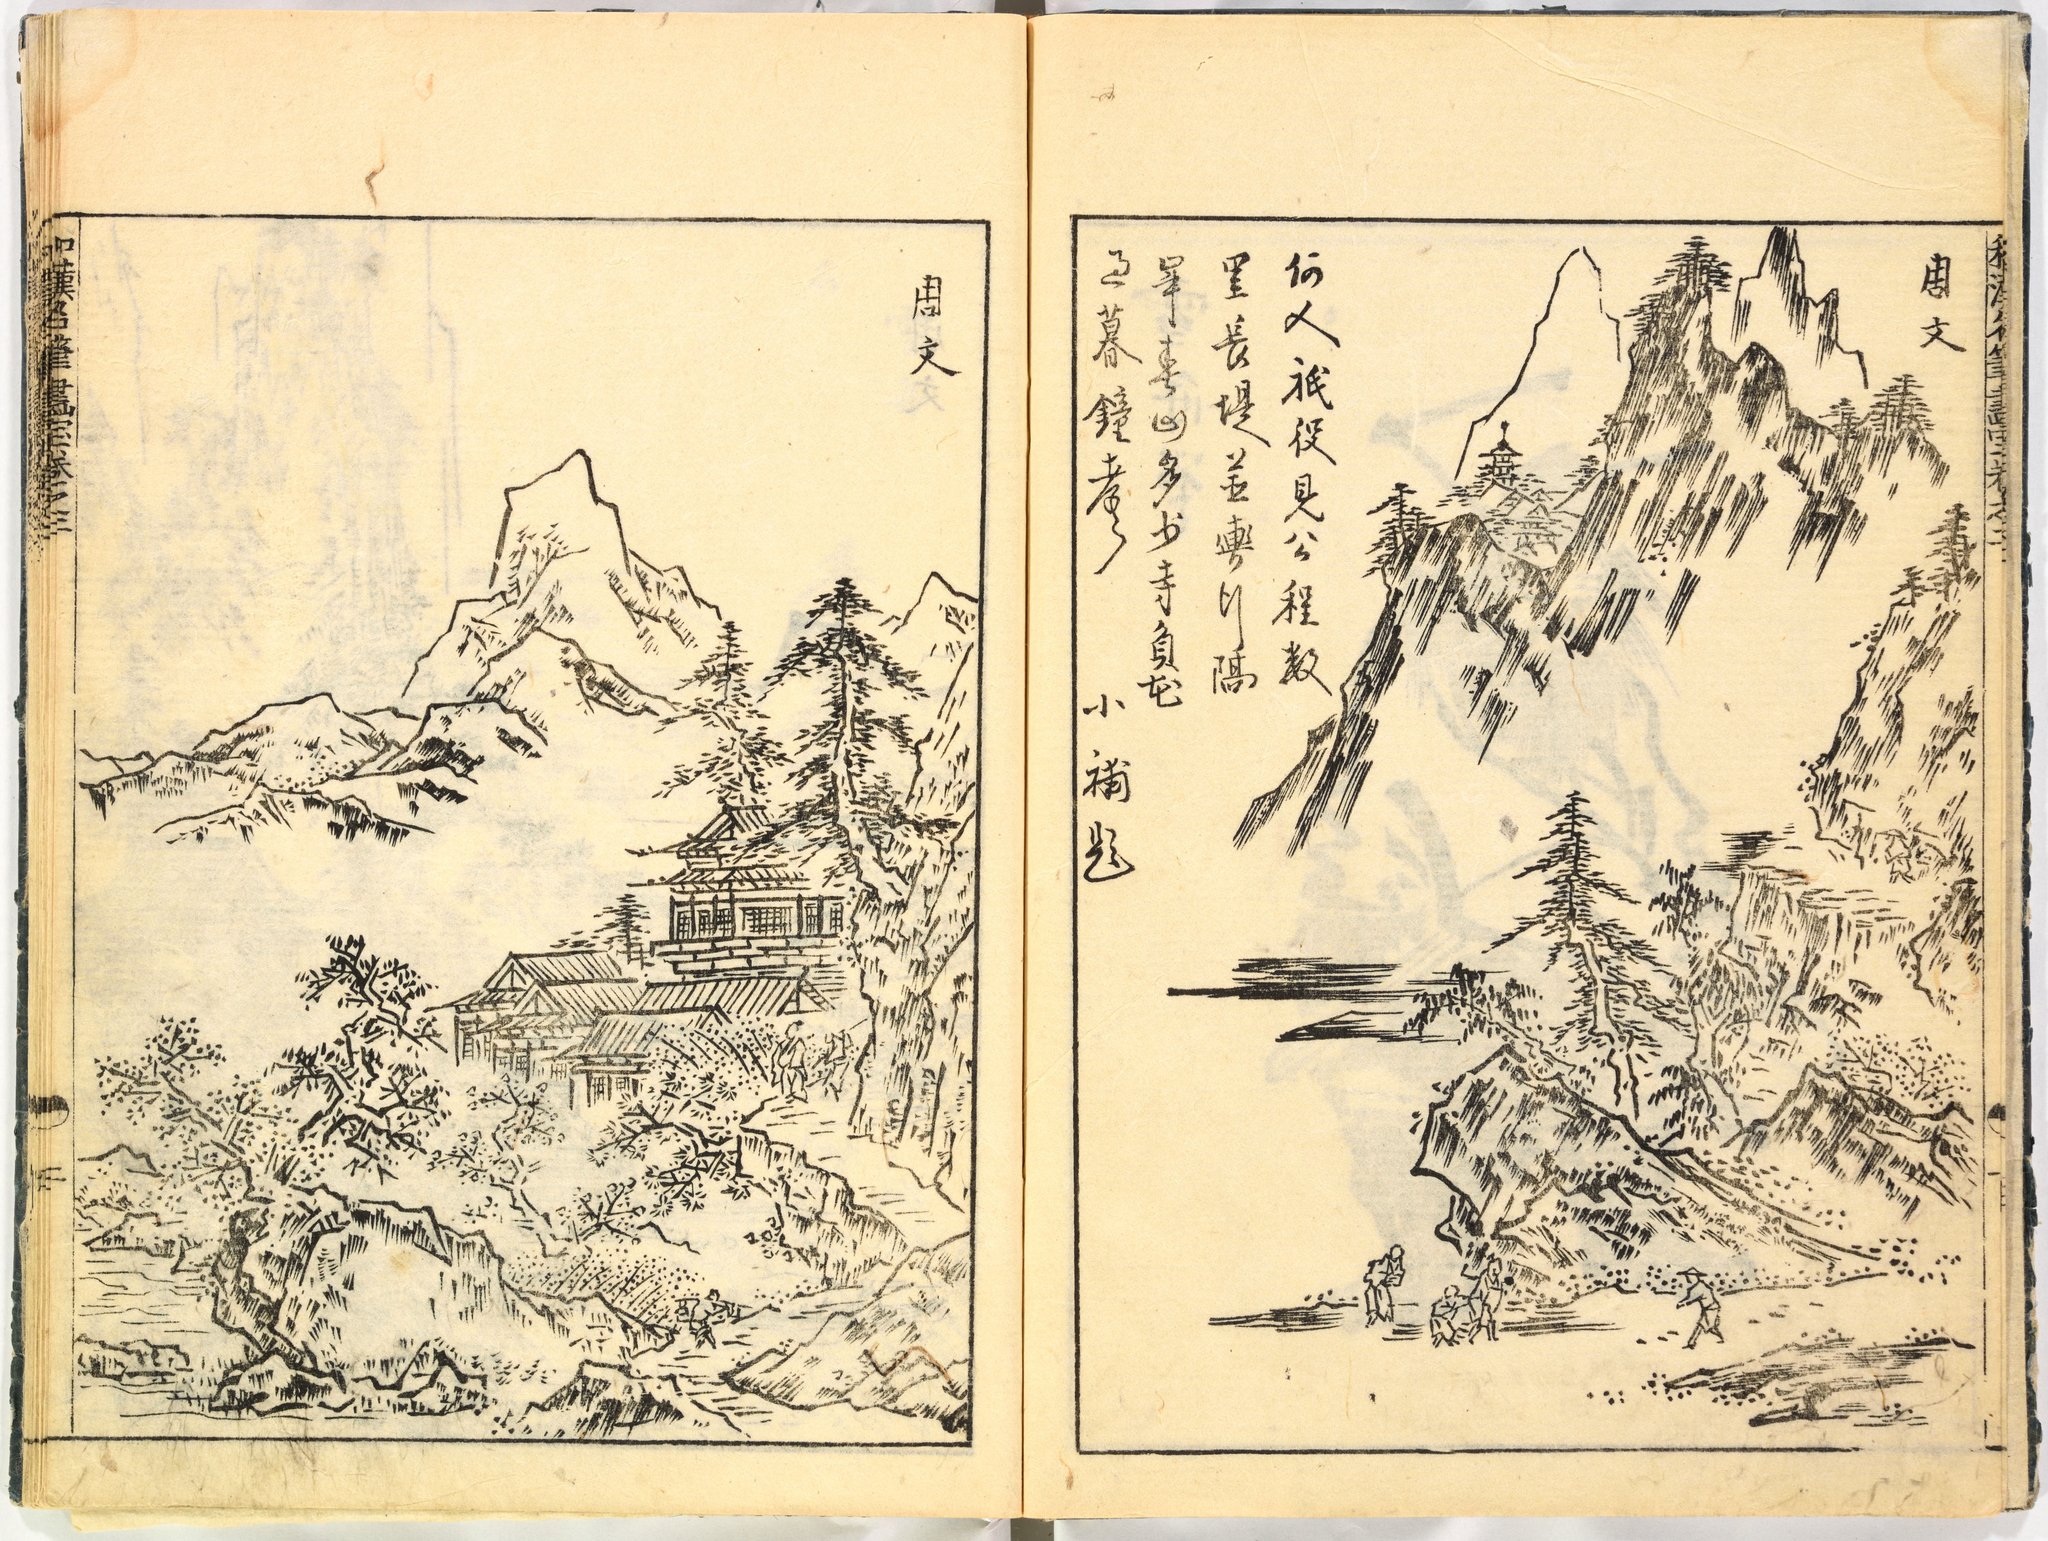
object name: illustrated book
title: Reproductions from Works by Famous Japanese Artists of Chinese School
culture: japanese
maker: sesshū tōyō 雪舟等楊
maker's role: artist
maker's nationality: japanese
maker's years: 1420-1506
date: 1818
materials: ink, paper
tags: houses,mountains,trees